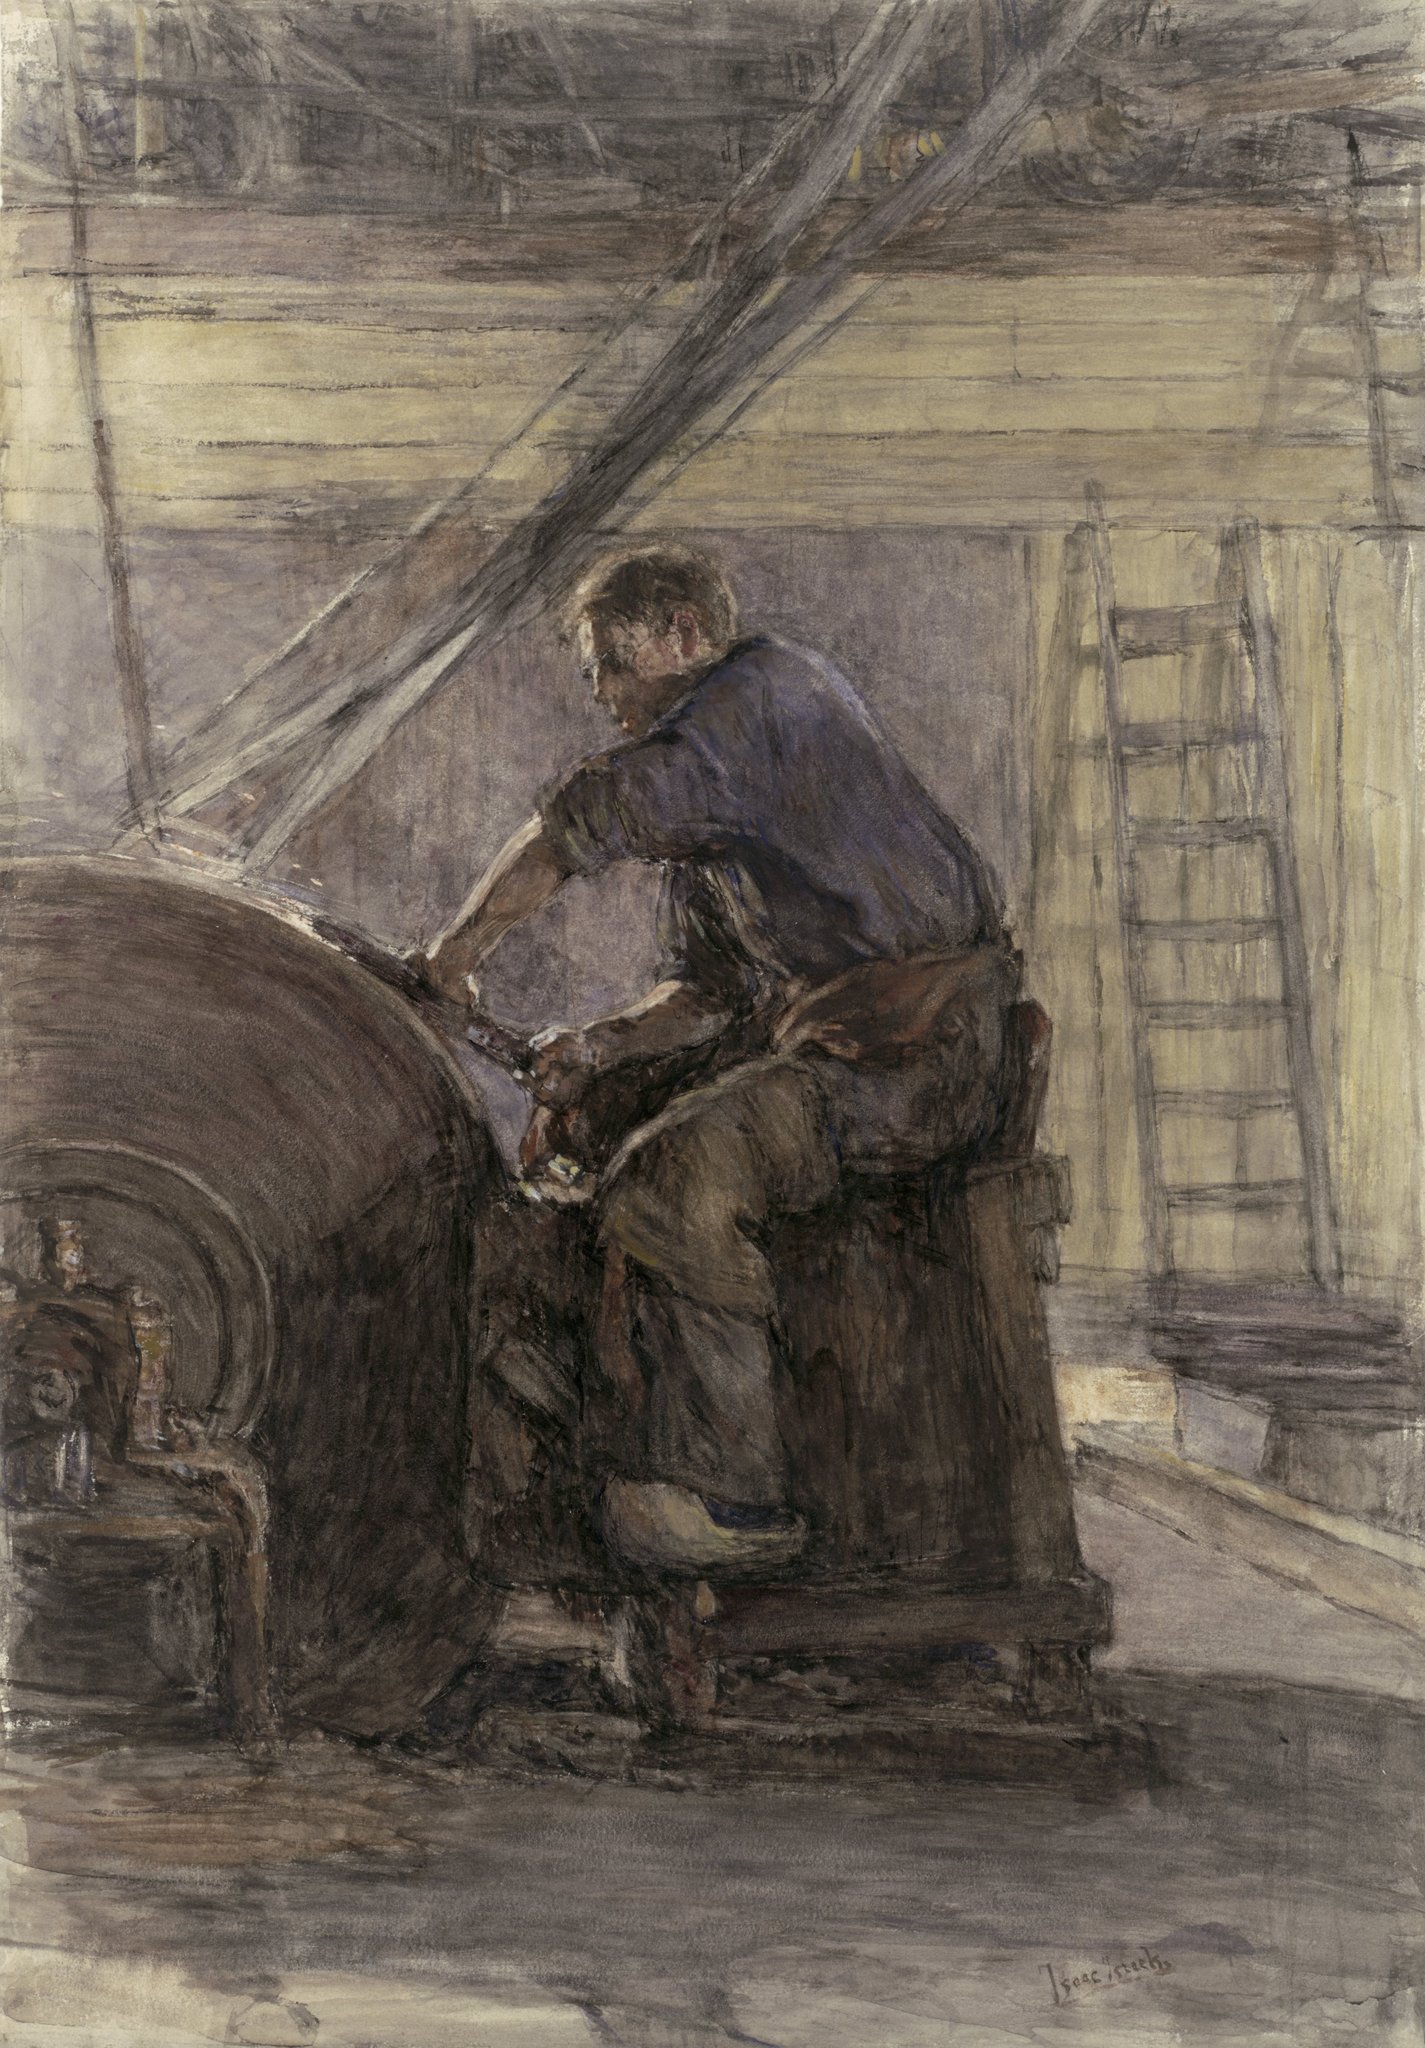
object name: watercolor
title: De slijper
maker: isaac israels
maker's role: draughtsman, painter, print maker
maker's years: 1865-1934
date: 1875-1919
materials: chalk, paper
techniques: brush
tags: sharpening, grinding (industrial processes), handicrafts ~ maintenance and repair, workshop-interior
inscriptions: signature: ‘Isaac Israels’